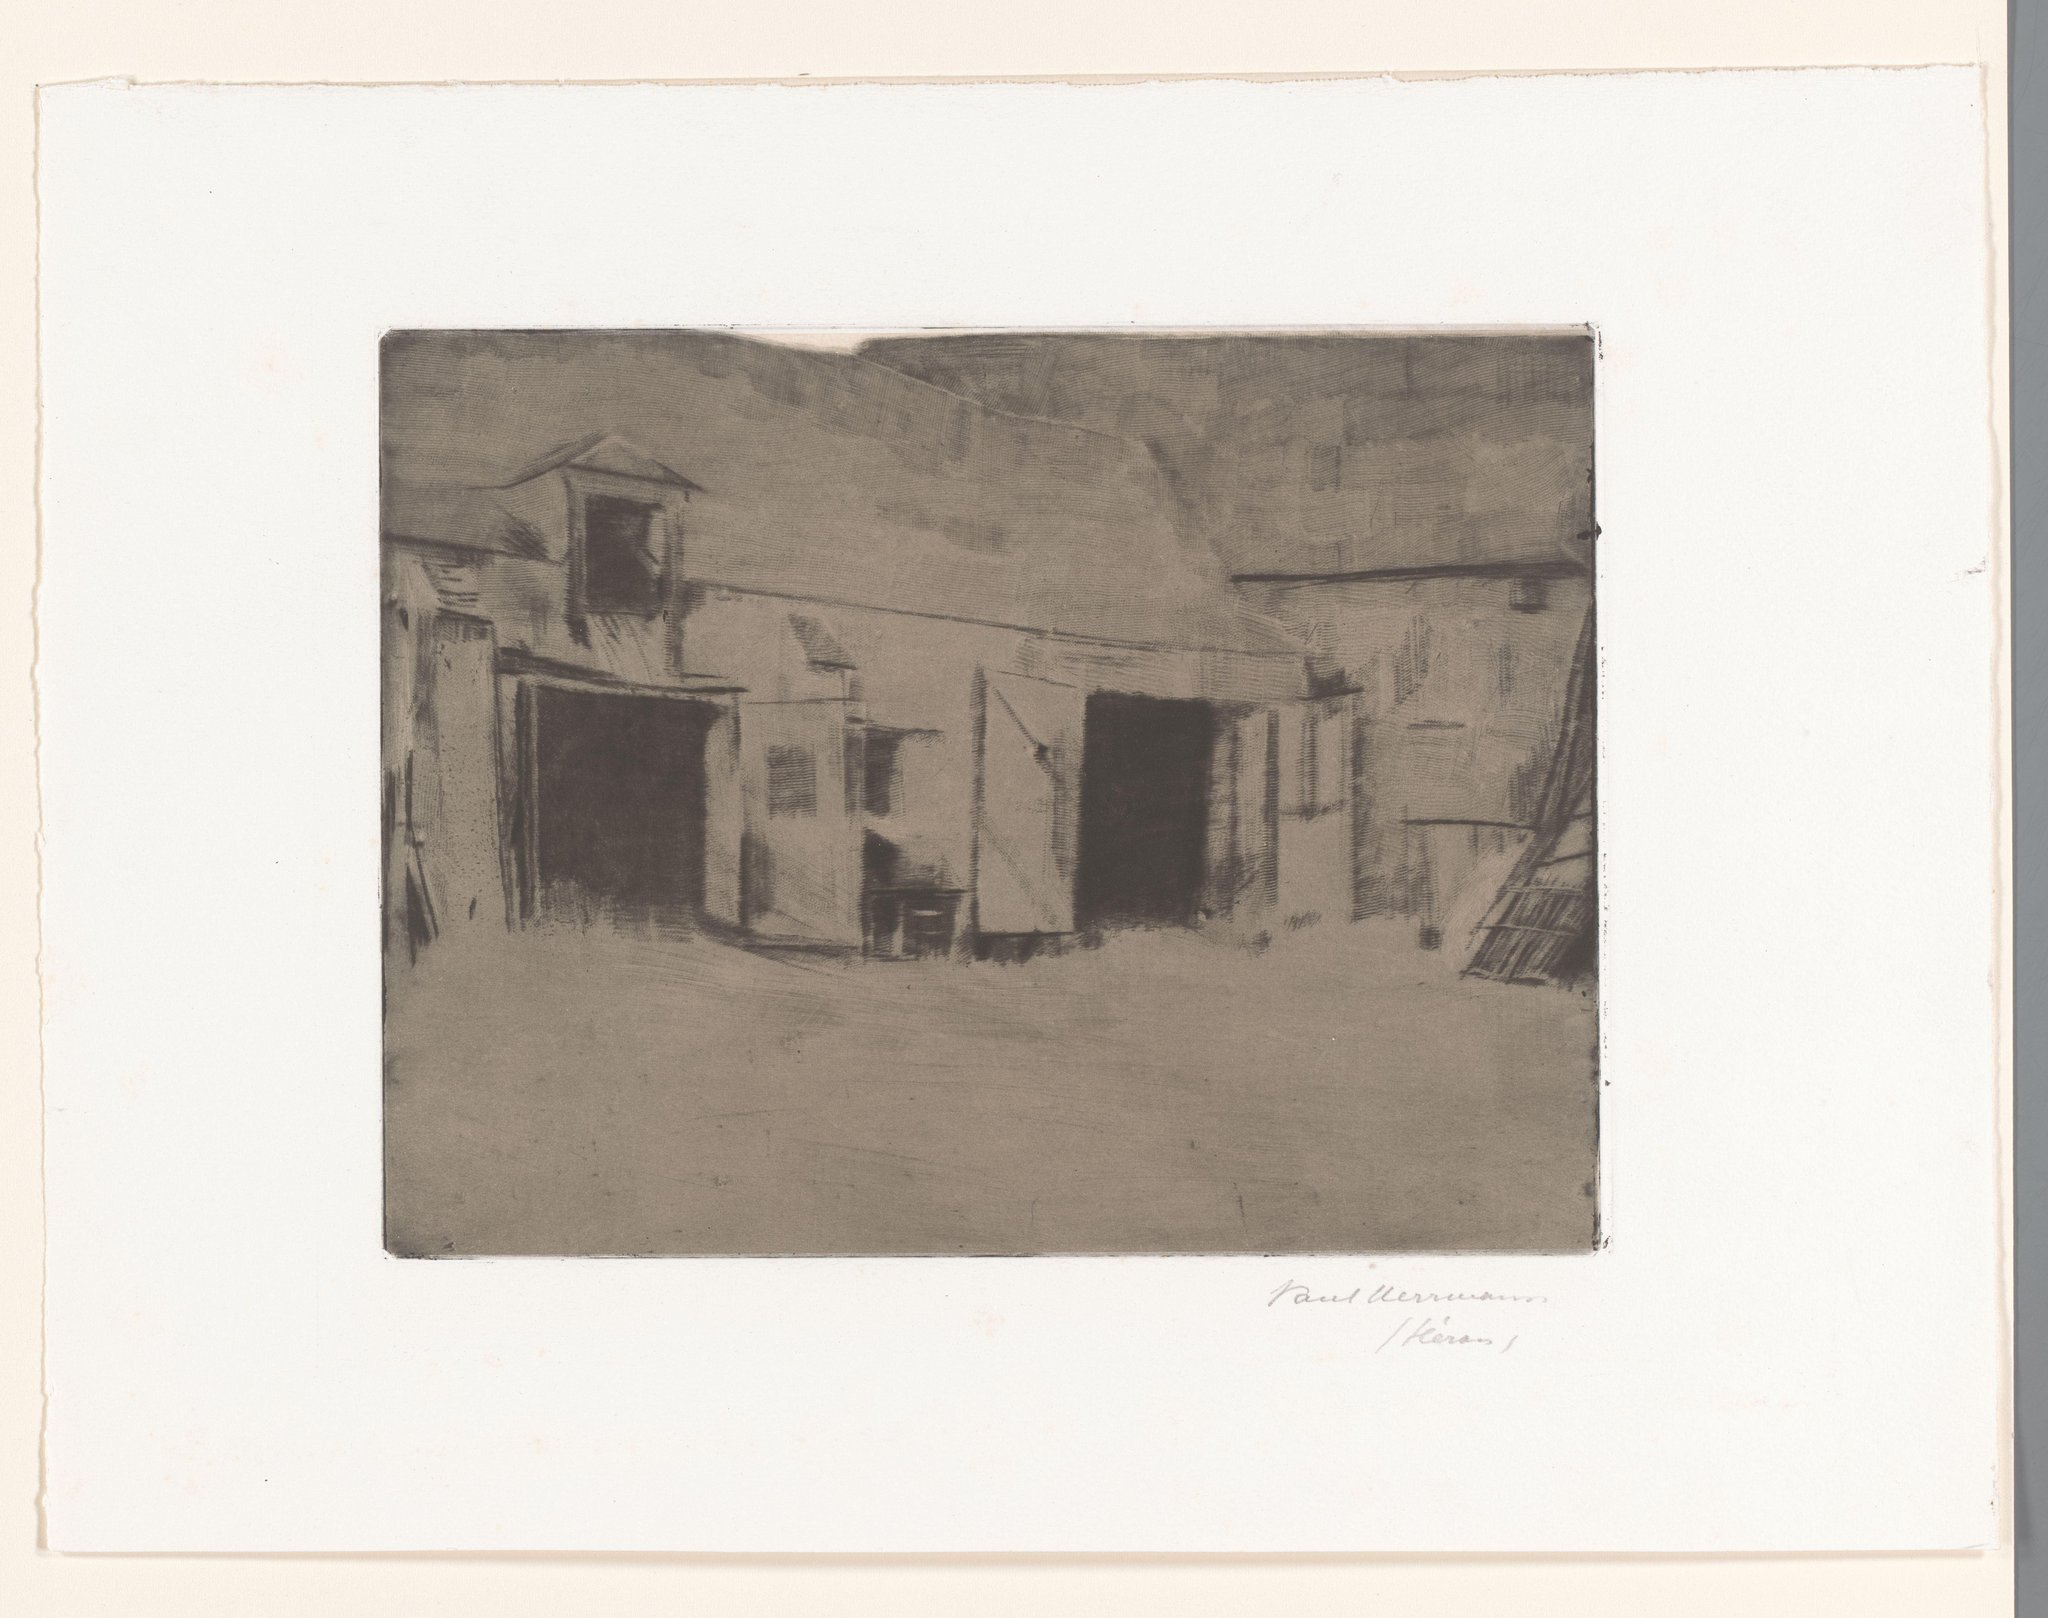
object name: print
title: Boerderij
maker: paul herrmann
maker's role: painter, print maker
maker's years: 1864-1944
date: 1900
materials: paper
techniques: roulette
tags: farm or solitary house in landscape, farm (building)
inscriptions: collector's mark: Lugt 2228